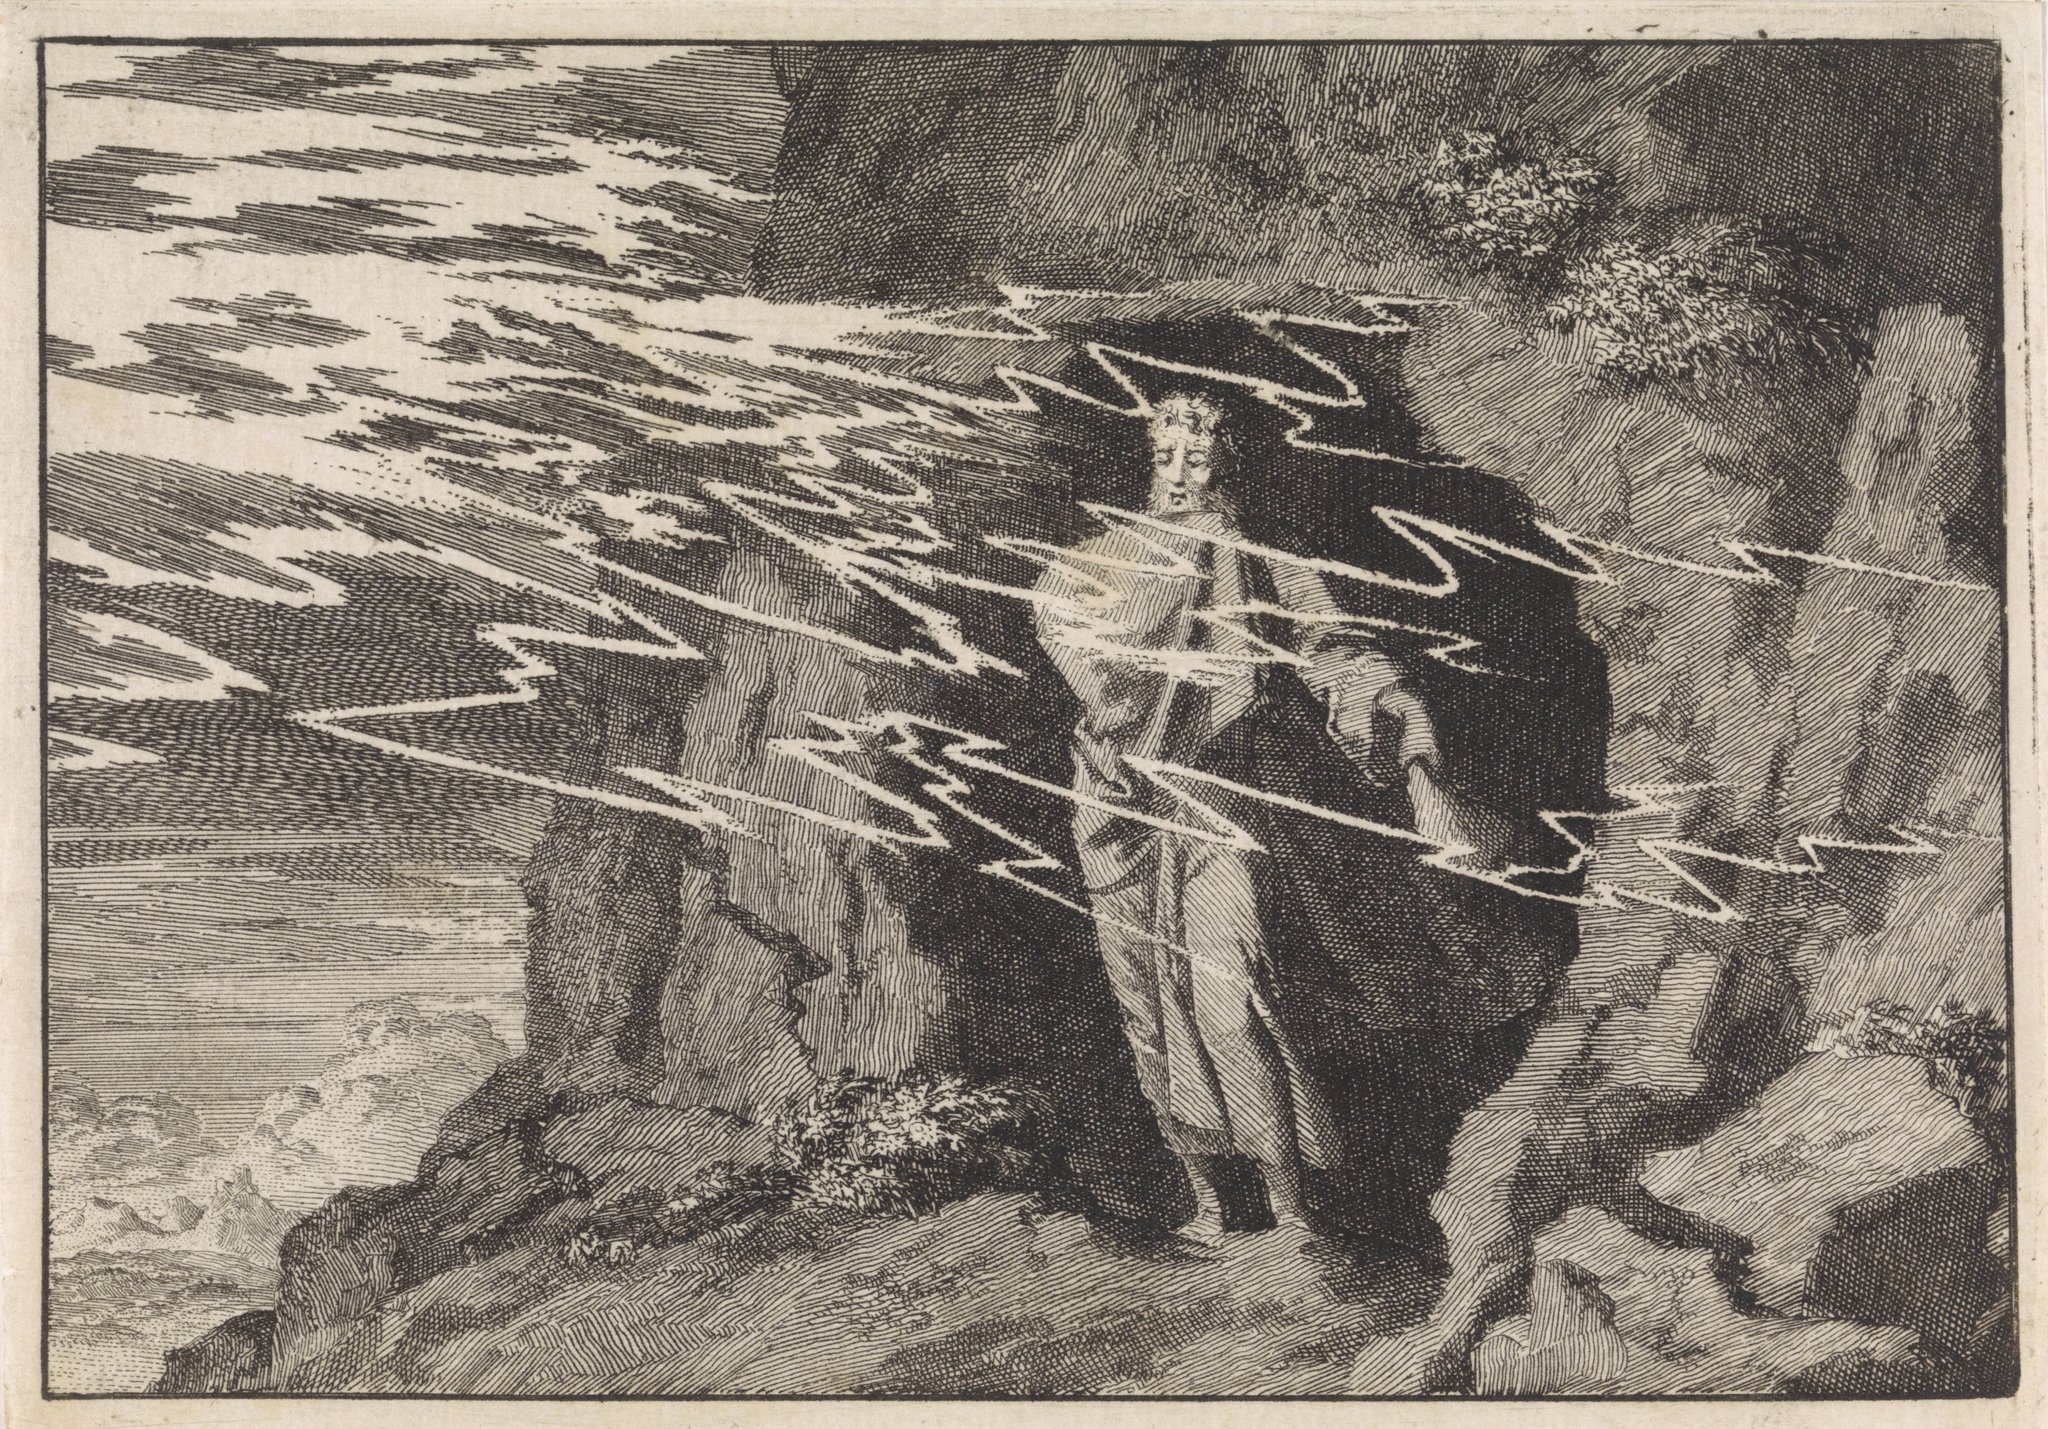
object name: print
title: Elia in de grot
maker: jan luyken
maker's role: draughtsman, print maker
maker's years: 1649-1712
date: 1704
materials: paper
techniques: etching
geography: amsterdam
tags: elijah comes to mount horeb where he dwells in a cave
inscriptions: collector's mark: Lugt 2228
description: Prent ook gebruikt als boekillustratie in: Josephus, Flavius. Alle de Werken, 2 delen. Amsterdam: Pieter Mortier, 1704, dl. 1, p. 208.